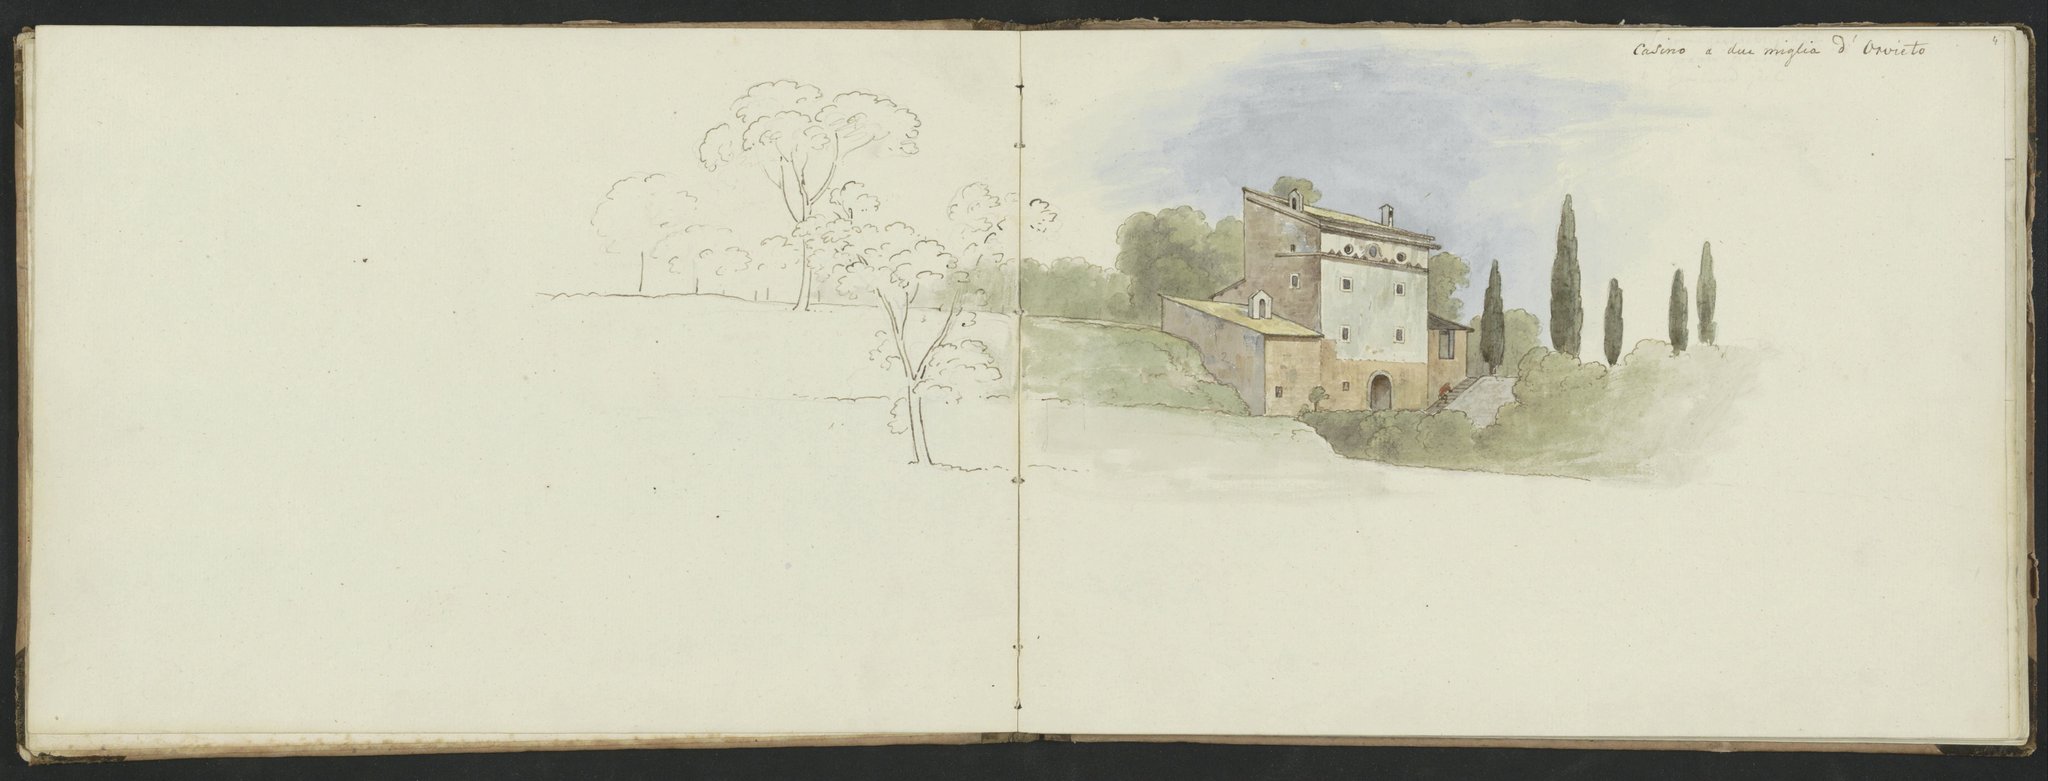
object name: sketchbook leaf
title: Landhuis nabij Orvieto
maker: abraham teerlink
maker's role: draughtsman, painter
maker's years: 1776-1857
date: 1808-1857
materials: ink, paper, pencil, watercolor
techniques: brush, pen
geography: orvieto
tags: trees: cypress, civic architecture; edifices; dwellings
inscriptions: annotation: ‘casino a due miglia d'Orvieto’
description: Gebouw met meerdere verdiepingen gelegen in een boomrijke omgeving met cipressen. Op de trap voor het gebouw loopt een figuur. Blad 3 verso en 4 recto uit een schetsboek met 28 bladen.